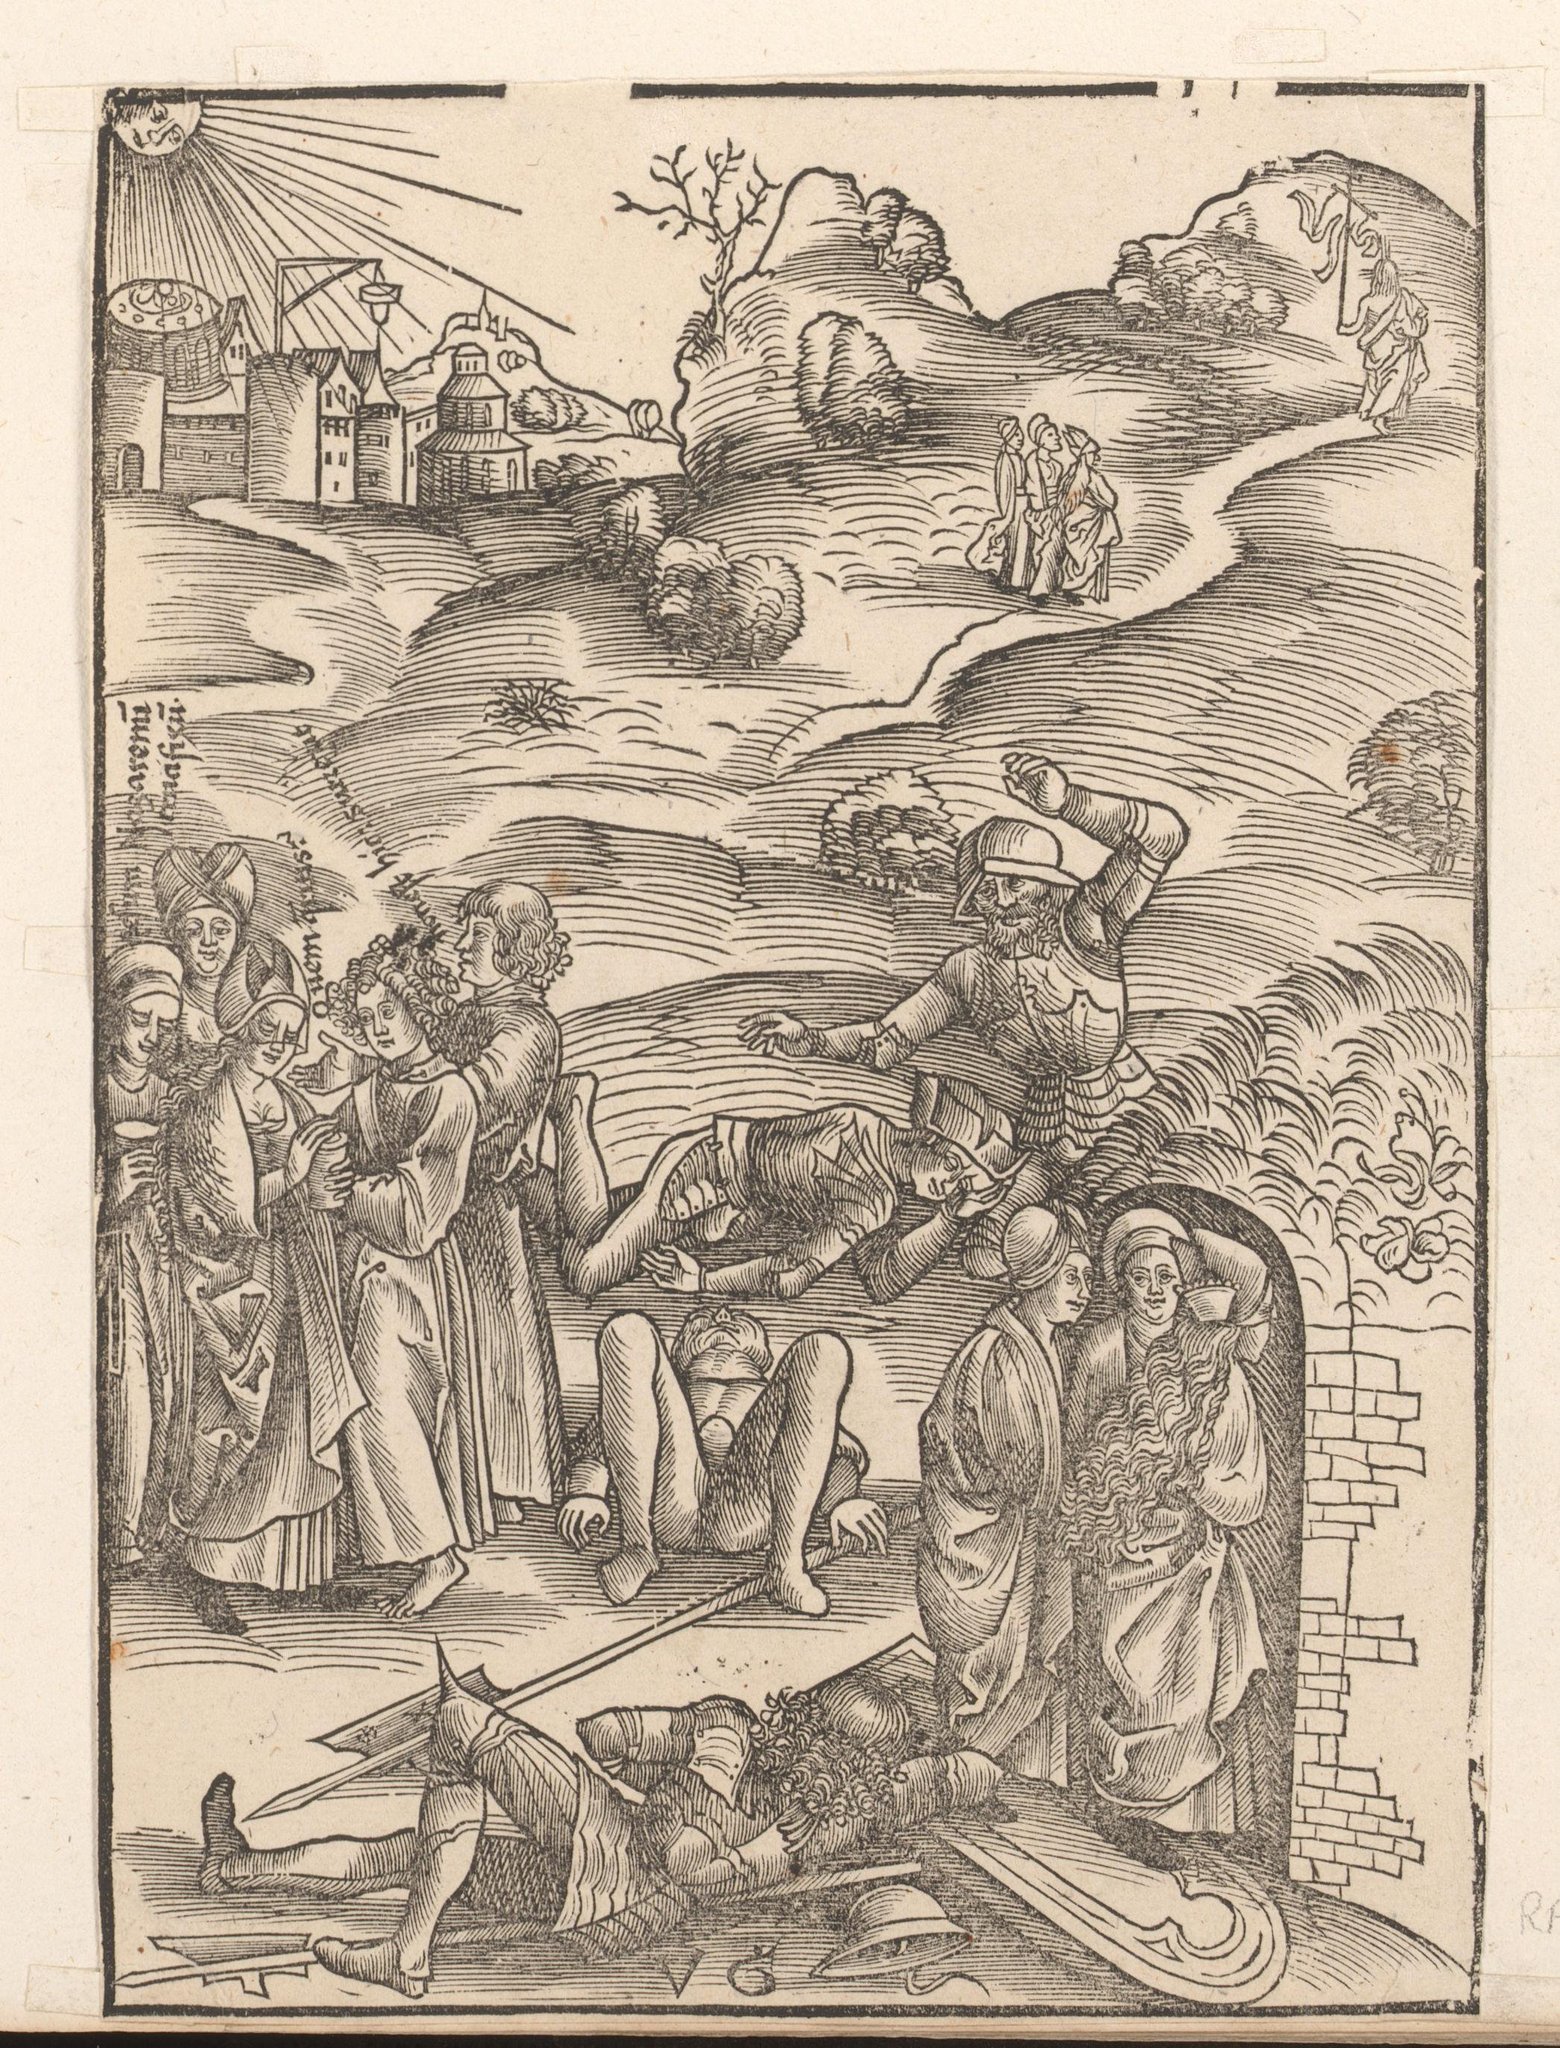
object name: album leaf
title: Drie vrouwen bij het lege graf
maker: urs graf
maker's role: draughtsman, print maker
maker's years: 1485-1528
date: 1506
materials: paper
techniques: woodcut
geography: switzerland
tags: the holy women (the three maries) on their way to or at the tomb, to anoint christ's body, angel(s) addressing the holy women ~ resurrection of christ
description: De drie vrouwen staan in de deuropening van het open graf. Daarnaast een slapende soldaat. Links vertellen twee mannen aan de vrouwen dat Christus is opgestaan. Op de achtergrond lopen de drie vrouwen achter de opgestane Christus aan. Prent maakt deel uit van een album.